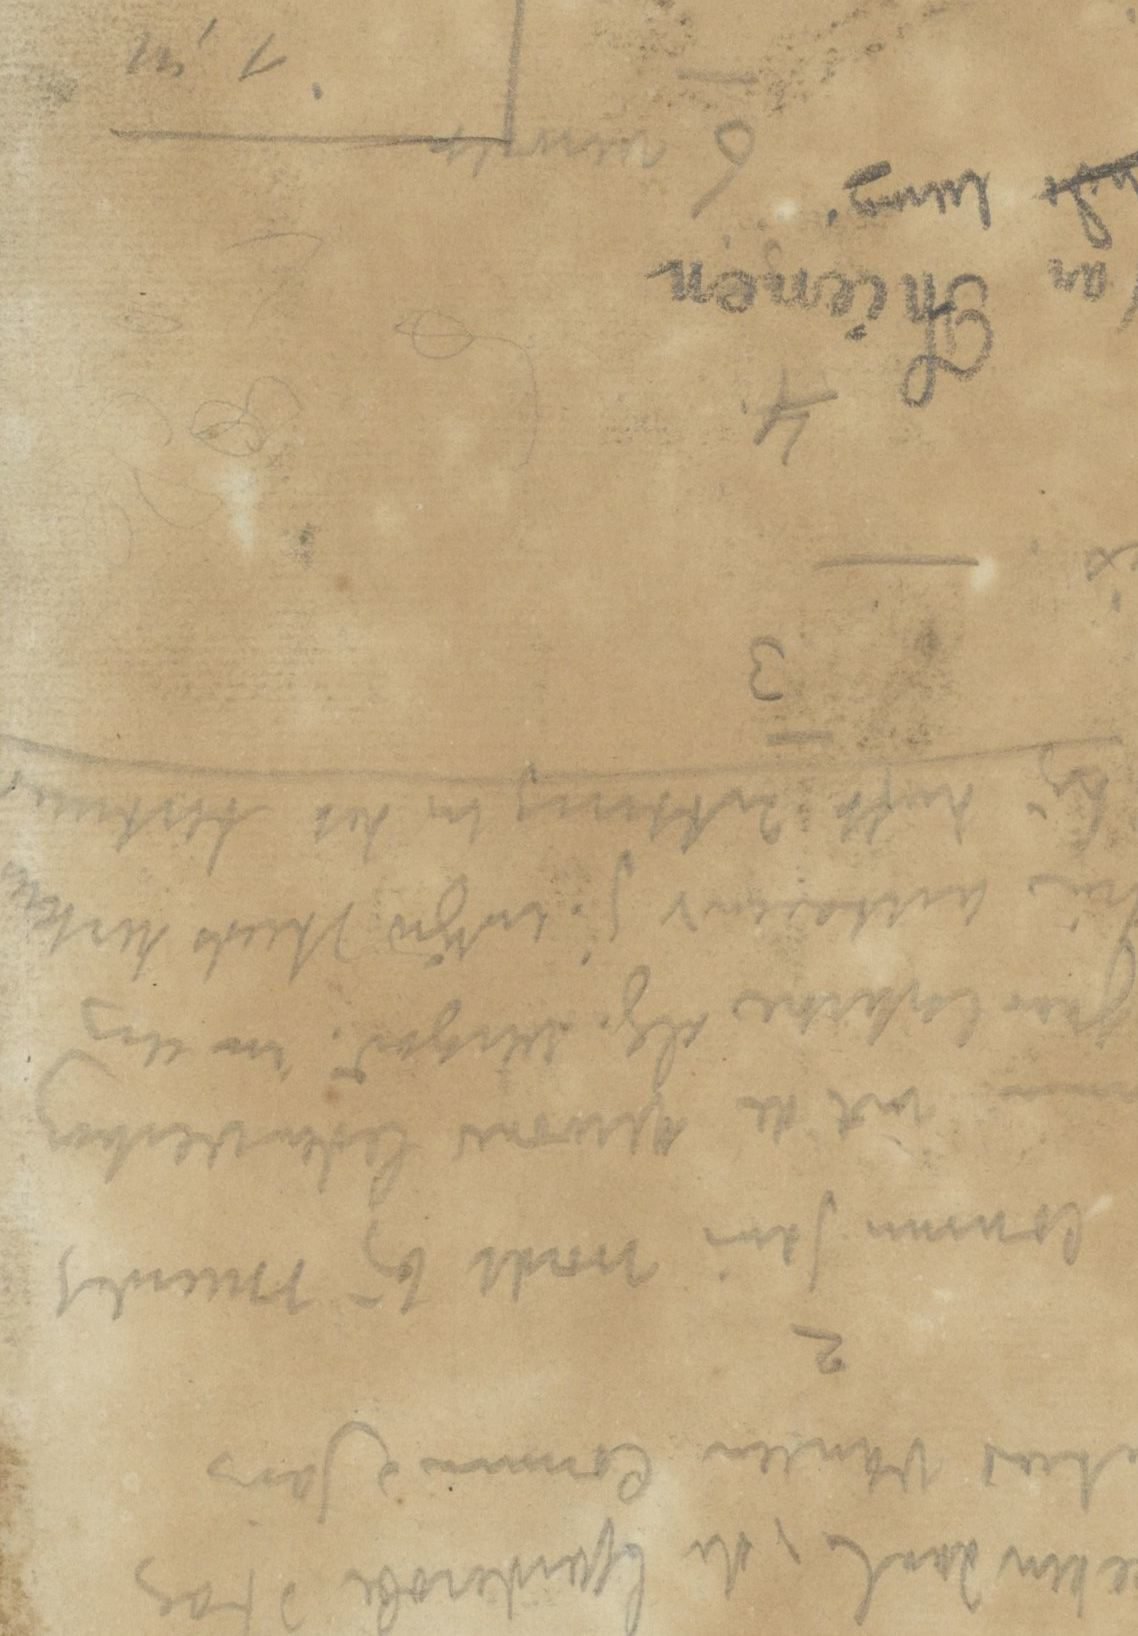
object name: sketchbook leaf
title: Annotaties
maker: george hendrik breitner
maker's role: draughtsman, painter, print maker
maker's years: 1857-1923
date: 1886-1903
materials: paper, pencil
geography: amsterdam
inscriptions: annotation: ‘De Teekenzaal en de Garderobe staan/ onder het beheer van een commissaris/ 2/ De commissaris bij [...]/ stemming uit de gewone leden verkozen/ op de jaarlijksche dg. vergad. [...] / voor drie achtereenv j. [...] steeds herkies/ baar, hij heeft zitting in het bestuur/ 3/ hij is/ 4./ G.J van Thienen [...]’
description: Pagina 31 uit een schetsboek met 15 bladen.